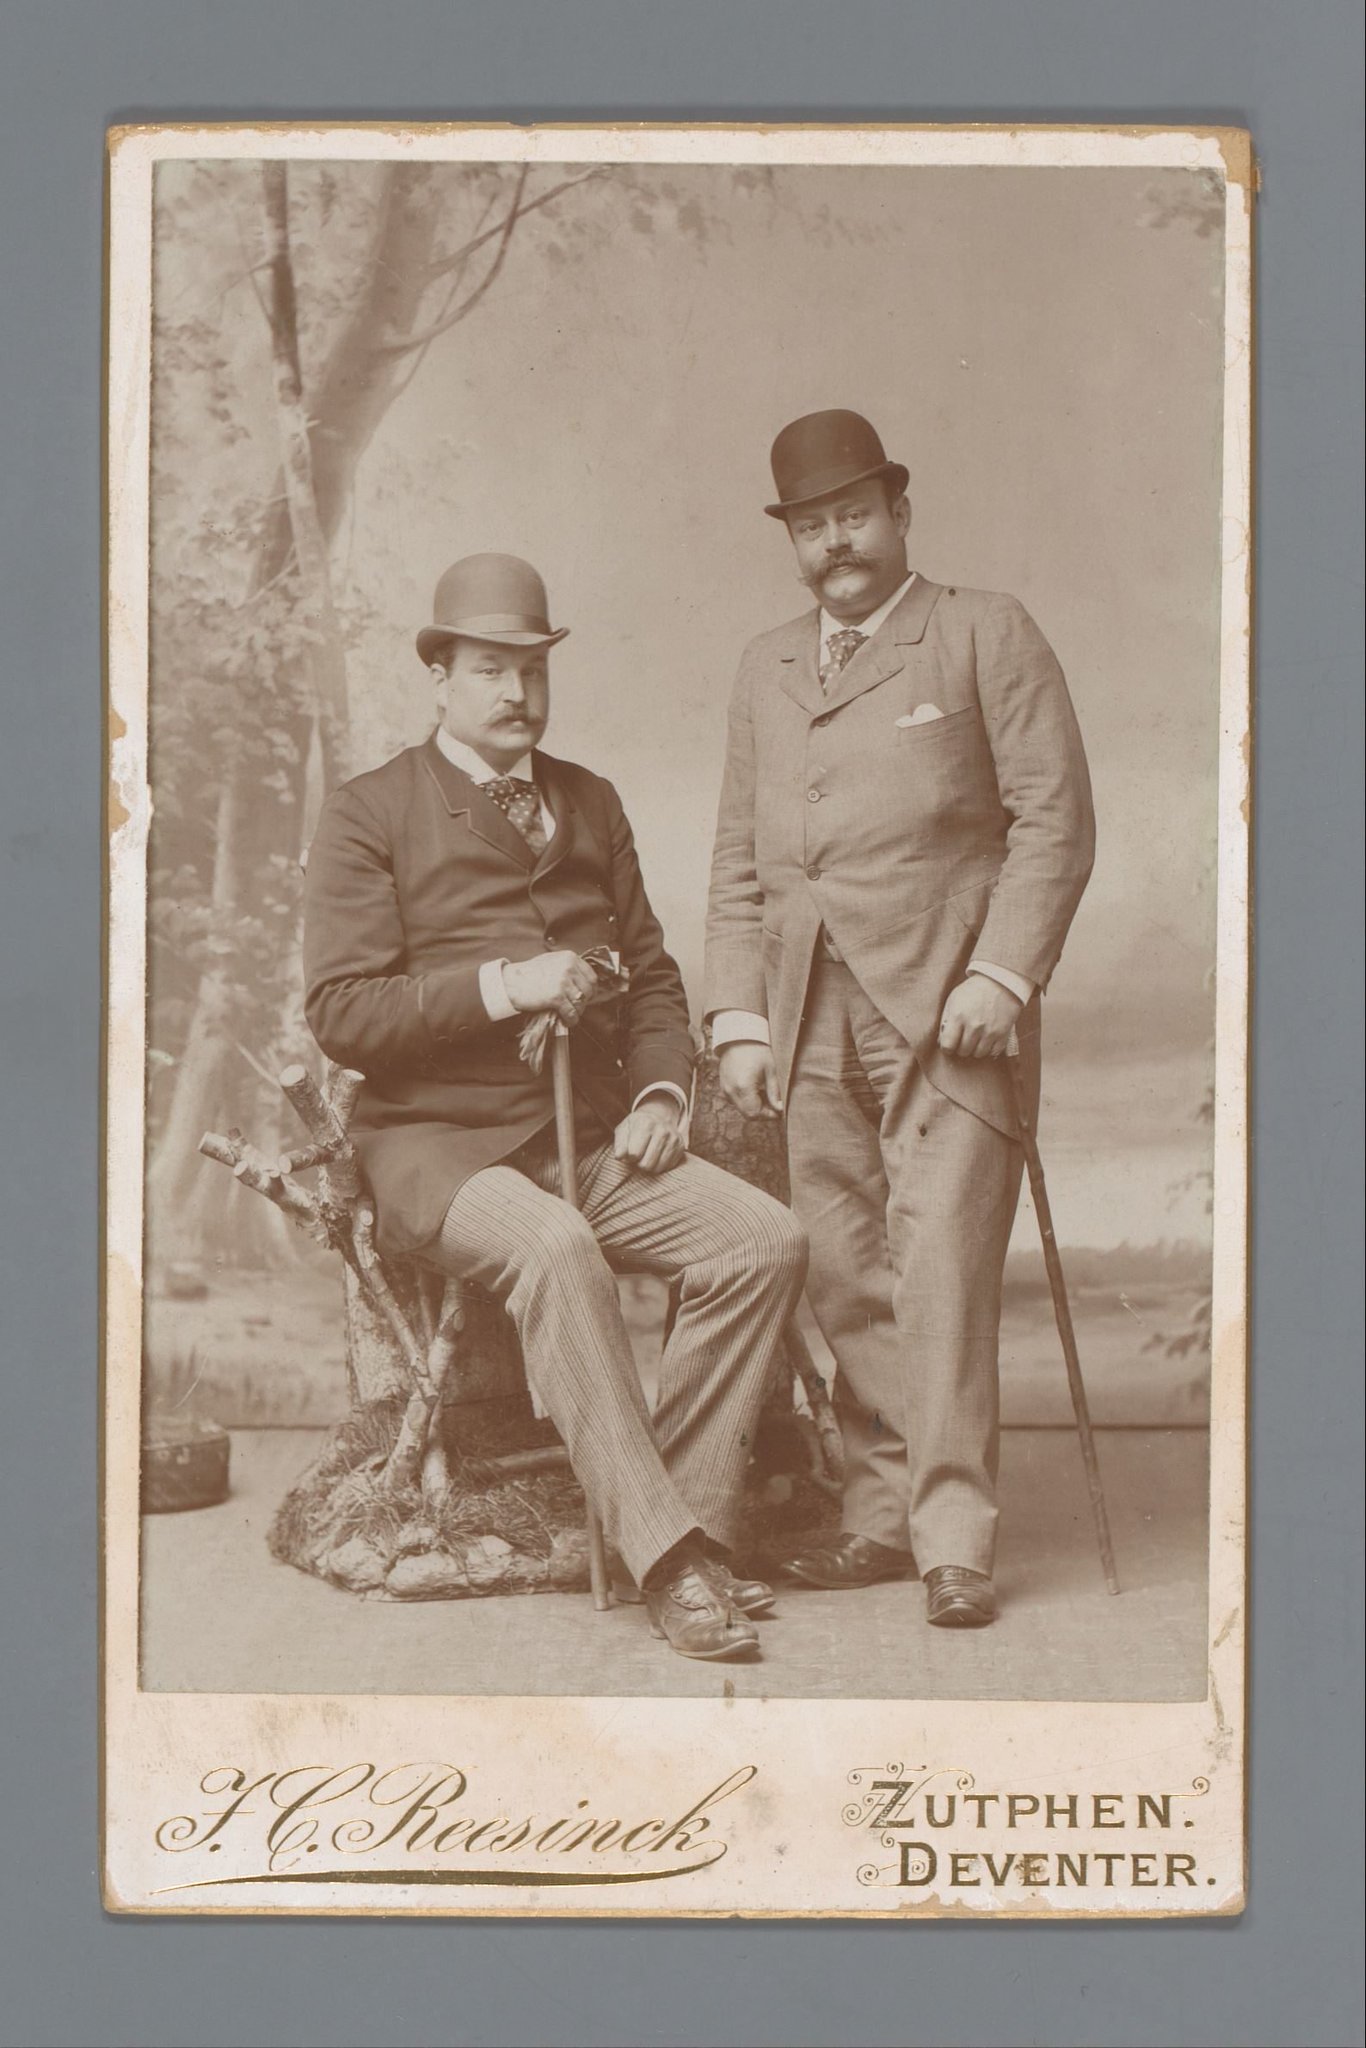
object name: cabinet photograph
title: Studioportret van twee onbekende mannen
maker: jacobus reesinck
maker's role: draughtsman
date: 1880-1900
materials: cardboard, photographic support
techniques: gelatin silver print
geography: zutphen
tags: anonymous historical persons portrayed in a double portrait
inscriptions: name: ‘J. C. Reesinck Photographisch Atelier Zutphen Hoek Berkelkade B. 300 Deventer Voorstad’